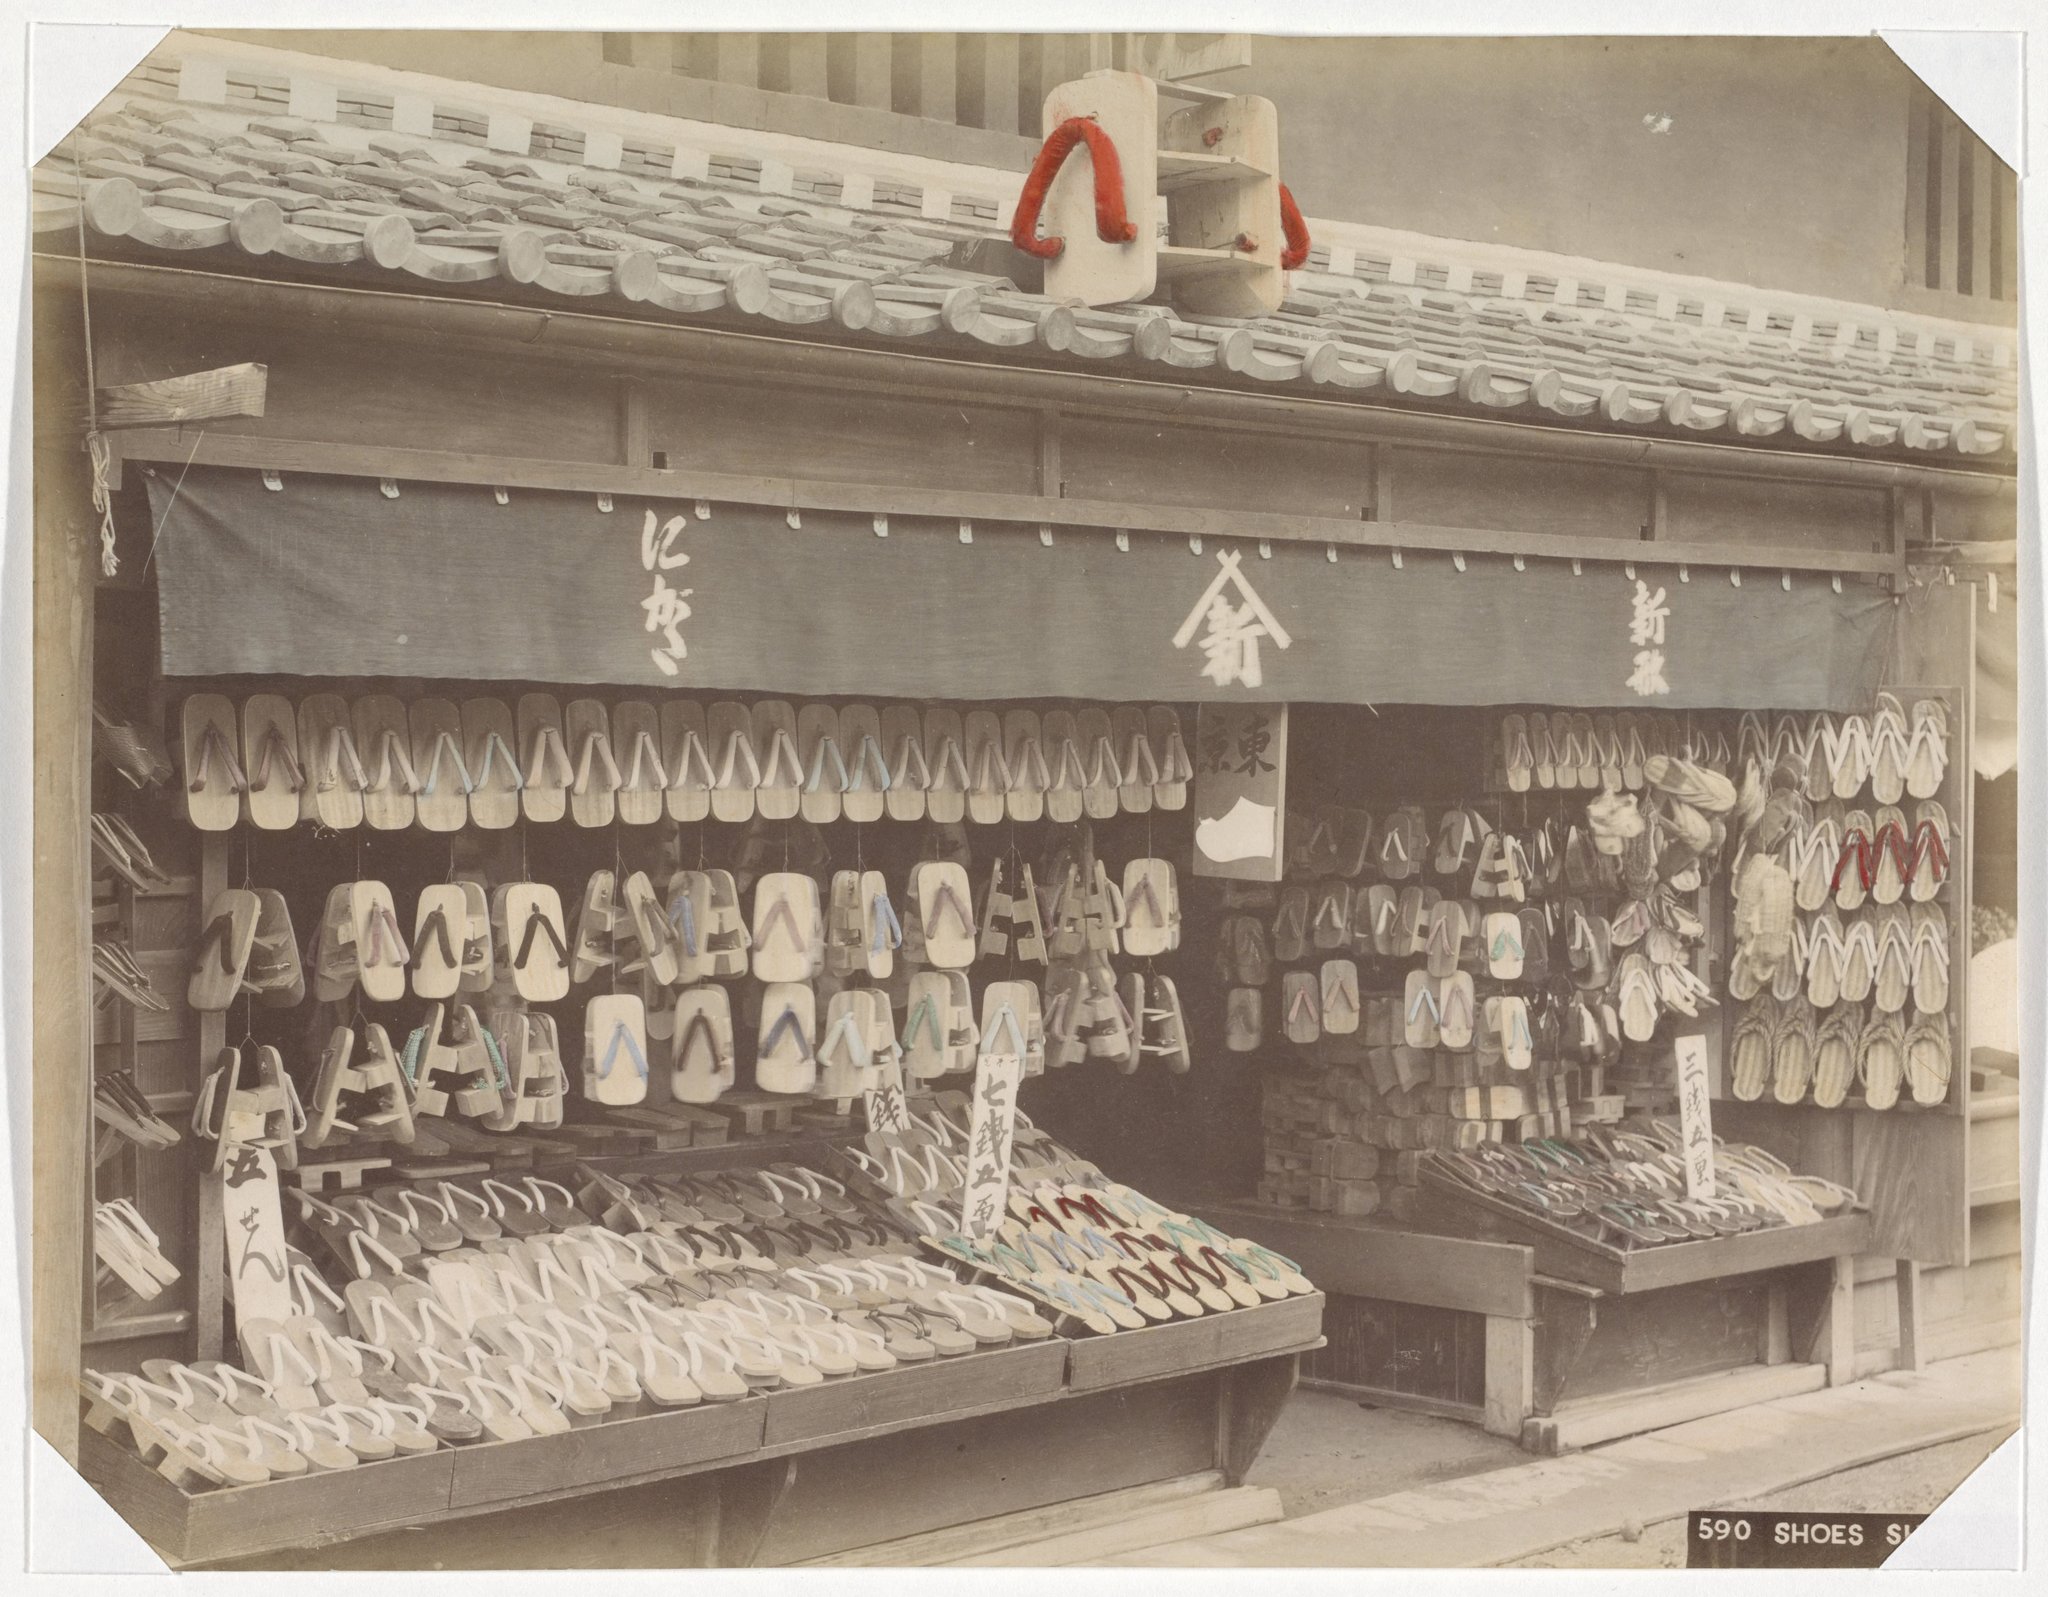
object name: photograph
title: Schoenenwinkel in Japan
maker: Anonymous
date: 1890-1894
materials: cardboard, paper, photographic support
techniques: albumen print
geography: japan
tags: shop, store, shoes, sandals, japan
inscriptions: negative number: ‘590’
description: Onderdeel van Album met 69 foto's van een reis door Japan.